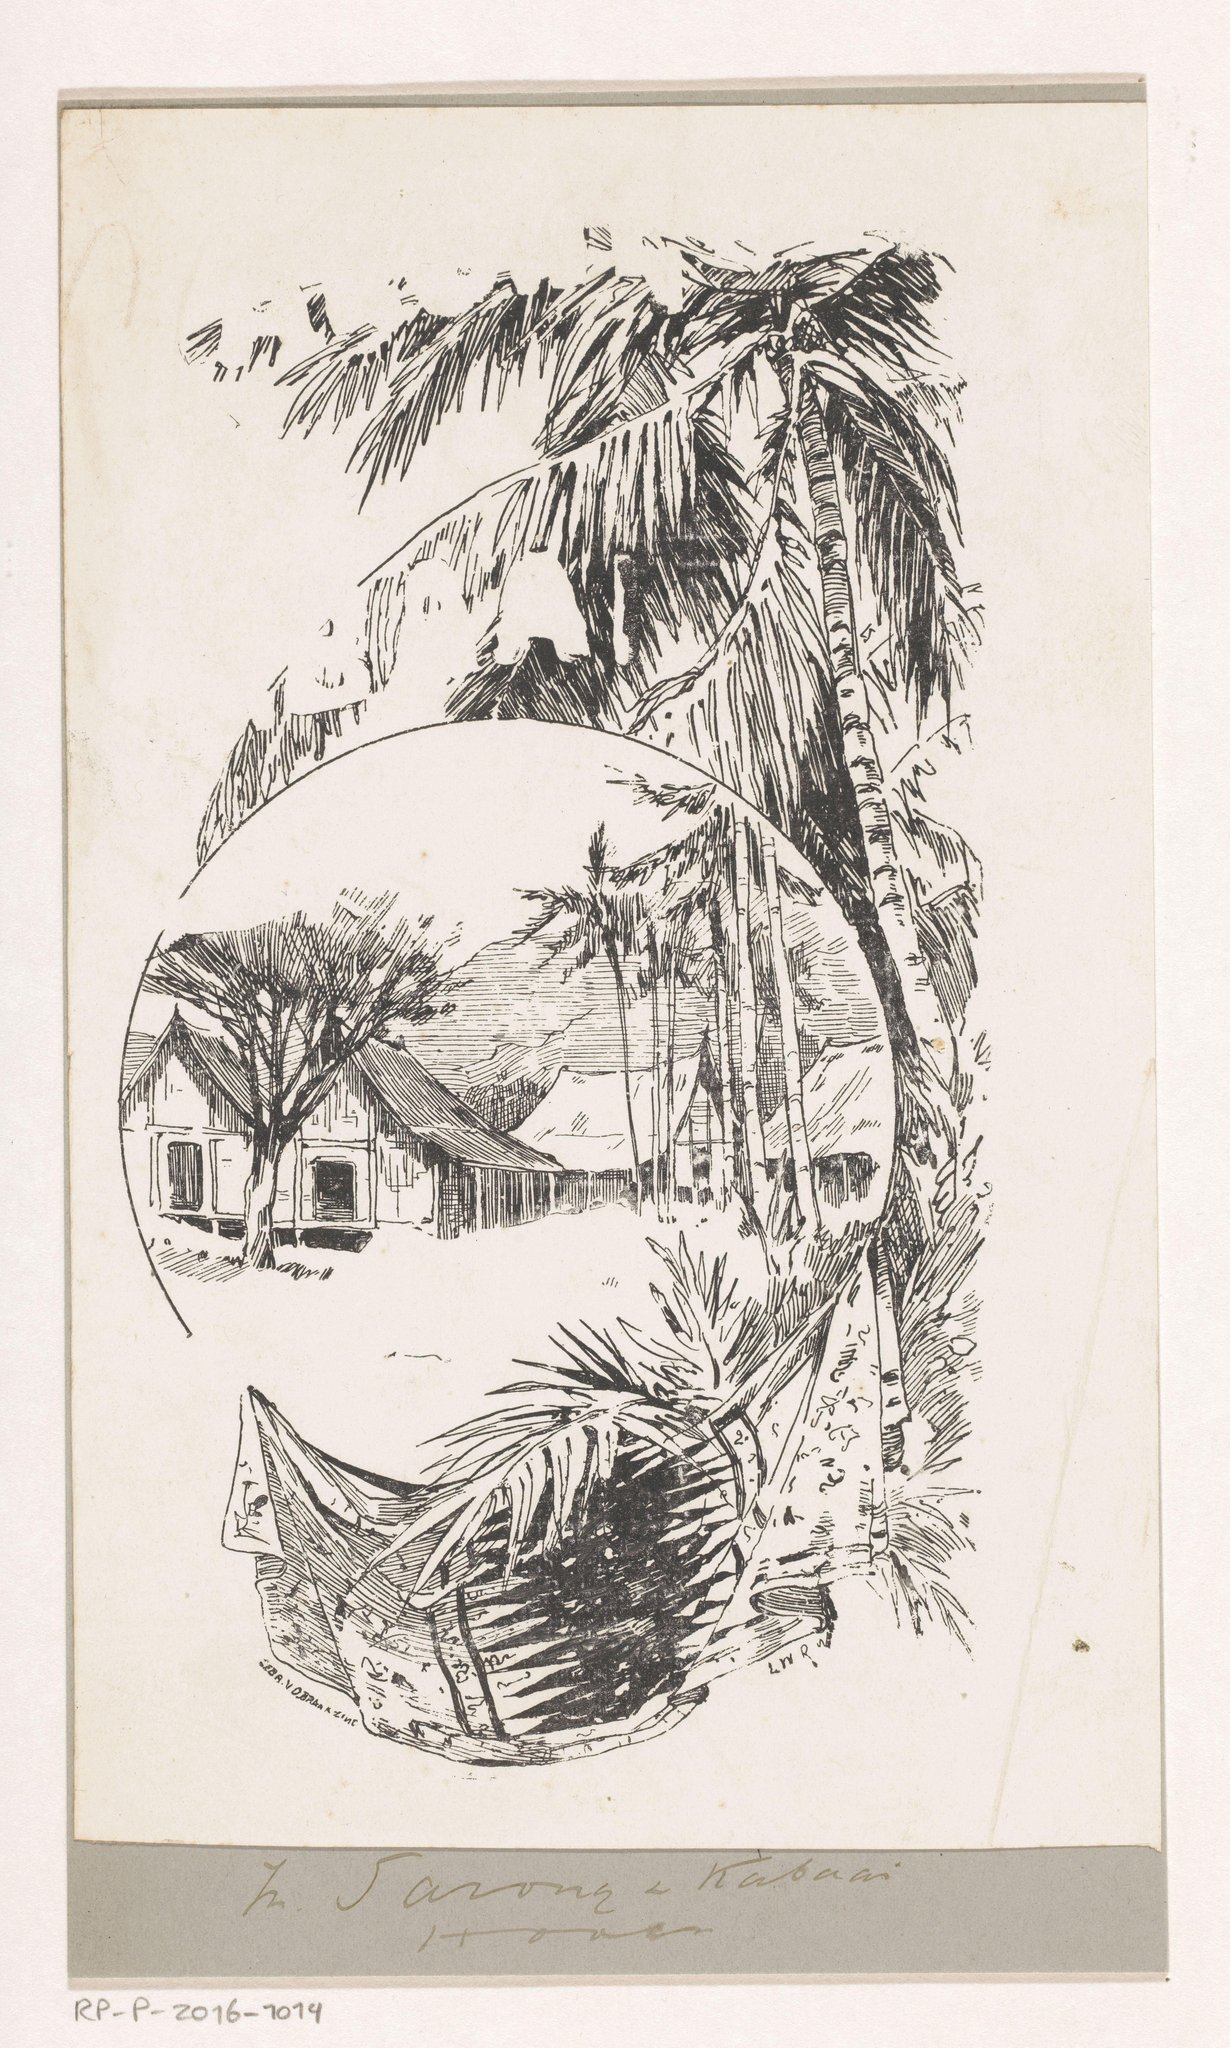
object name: photomechanical print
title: Bandontwerp voor: Thérèse Hoven, In sarong en kabaai, 1892-1894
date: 1892-1894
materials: cardboard, paper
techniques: printing block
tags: landscapes in the non-temperate zone, exotic landscapes, trees: palm-tree, drapery, draped garment, 'gewandgebung', dutch east indies, the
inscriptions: annotation: ‘In Sarong en Kabaai/ [...]’, collector's mark: Lugt 2228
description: In een cirkel weergegeven gezicht op vier huizen in een landschap in Nederlands-Indië. Rond de cirkel palmbomen en een uitgevouwen gedrapeerde sarong.